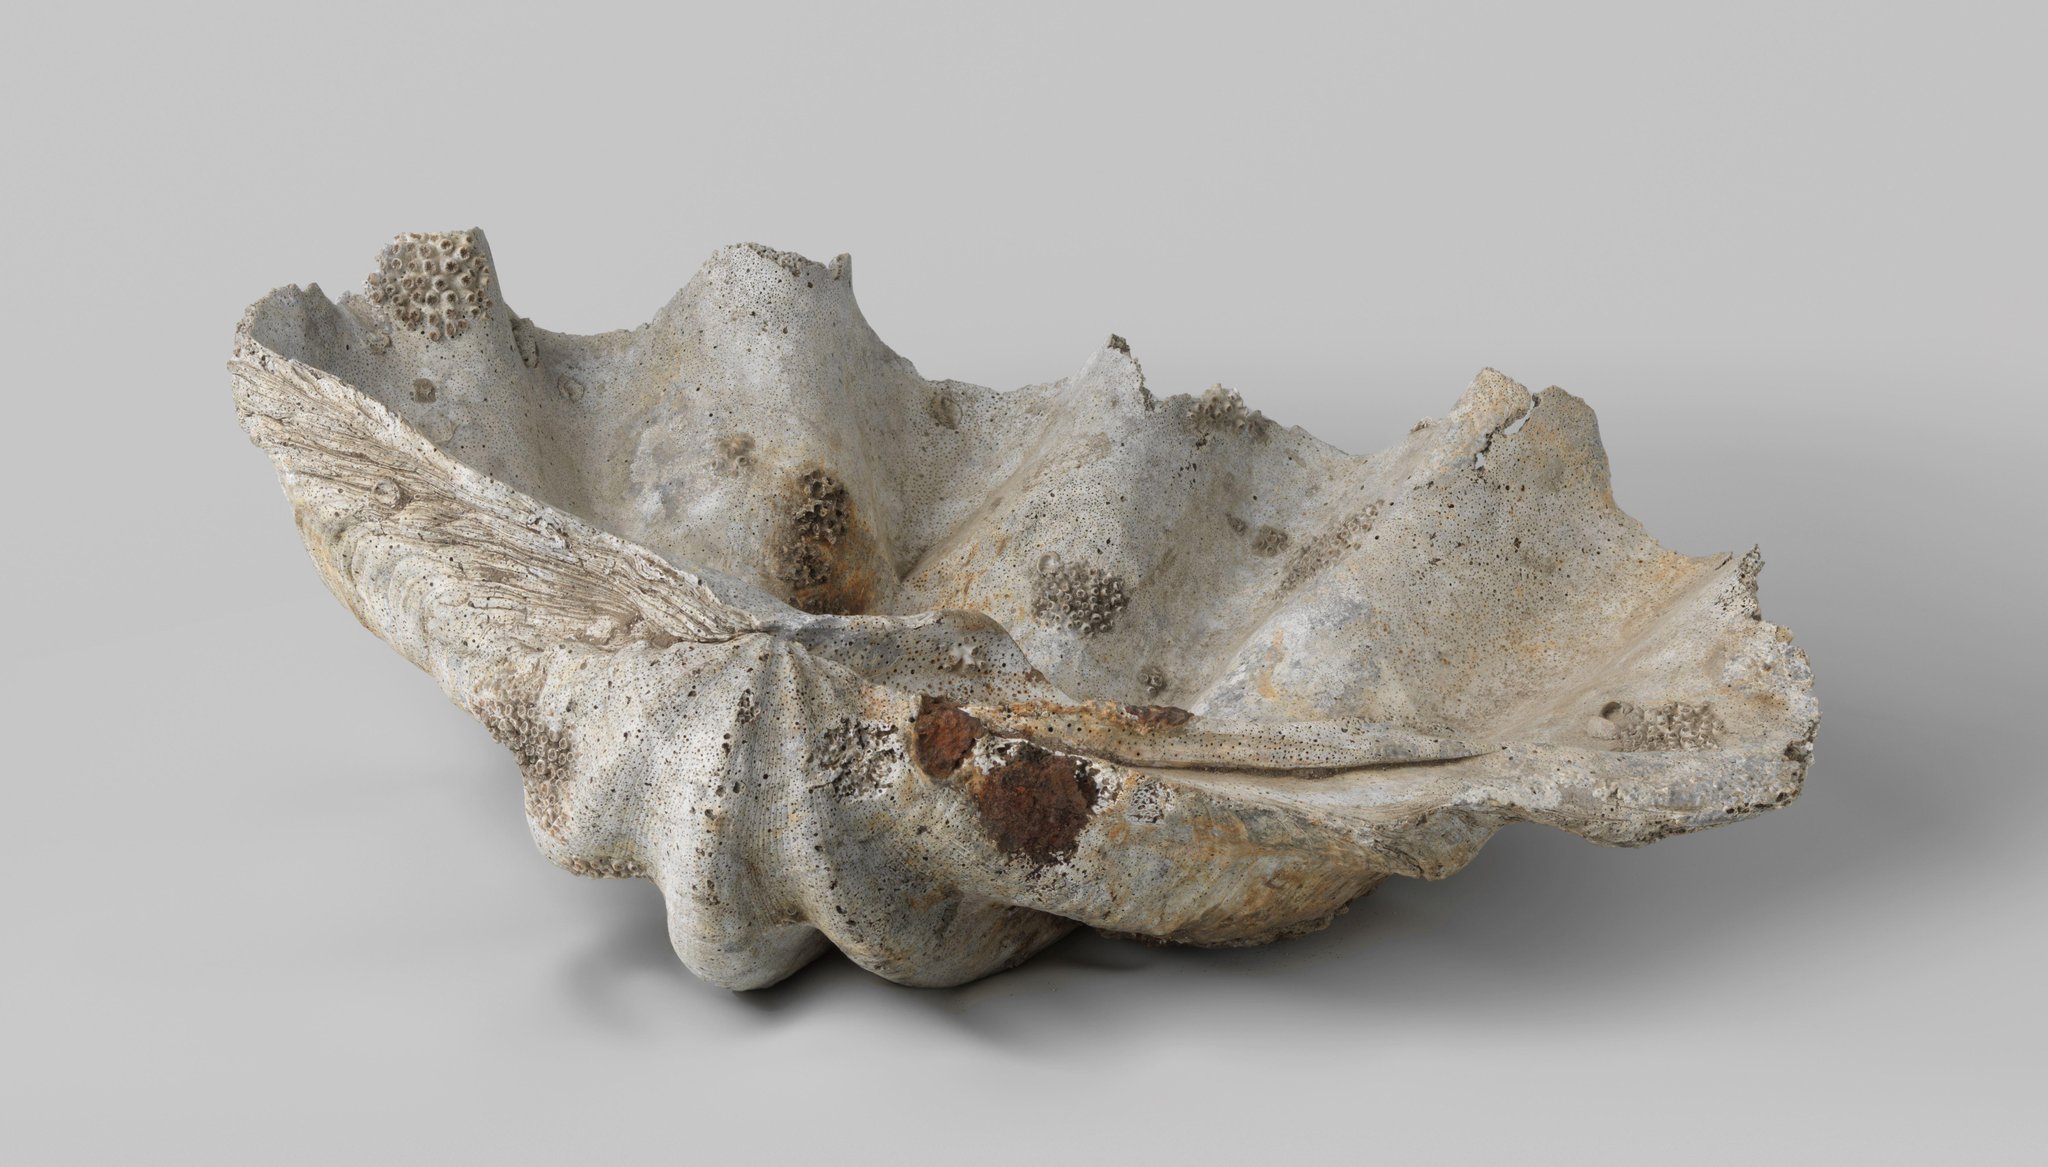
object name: tridacna gigas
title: Giant Clam (Tridacna gigas) from the wreck of the Dutch East Indiaman Witte Leeuw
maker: niet van toepassing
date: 1613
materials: shell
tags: verenigde oostindische compagnie, sint-helena